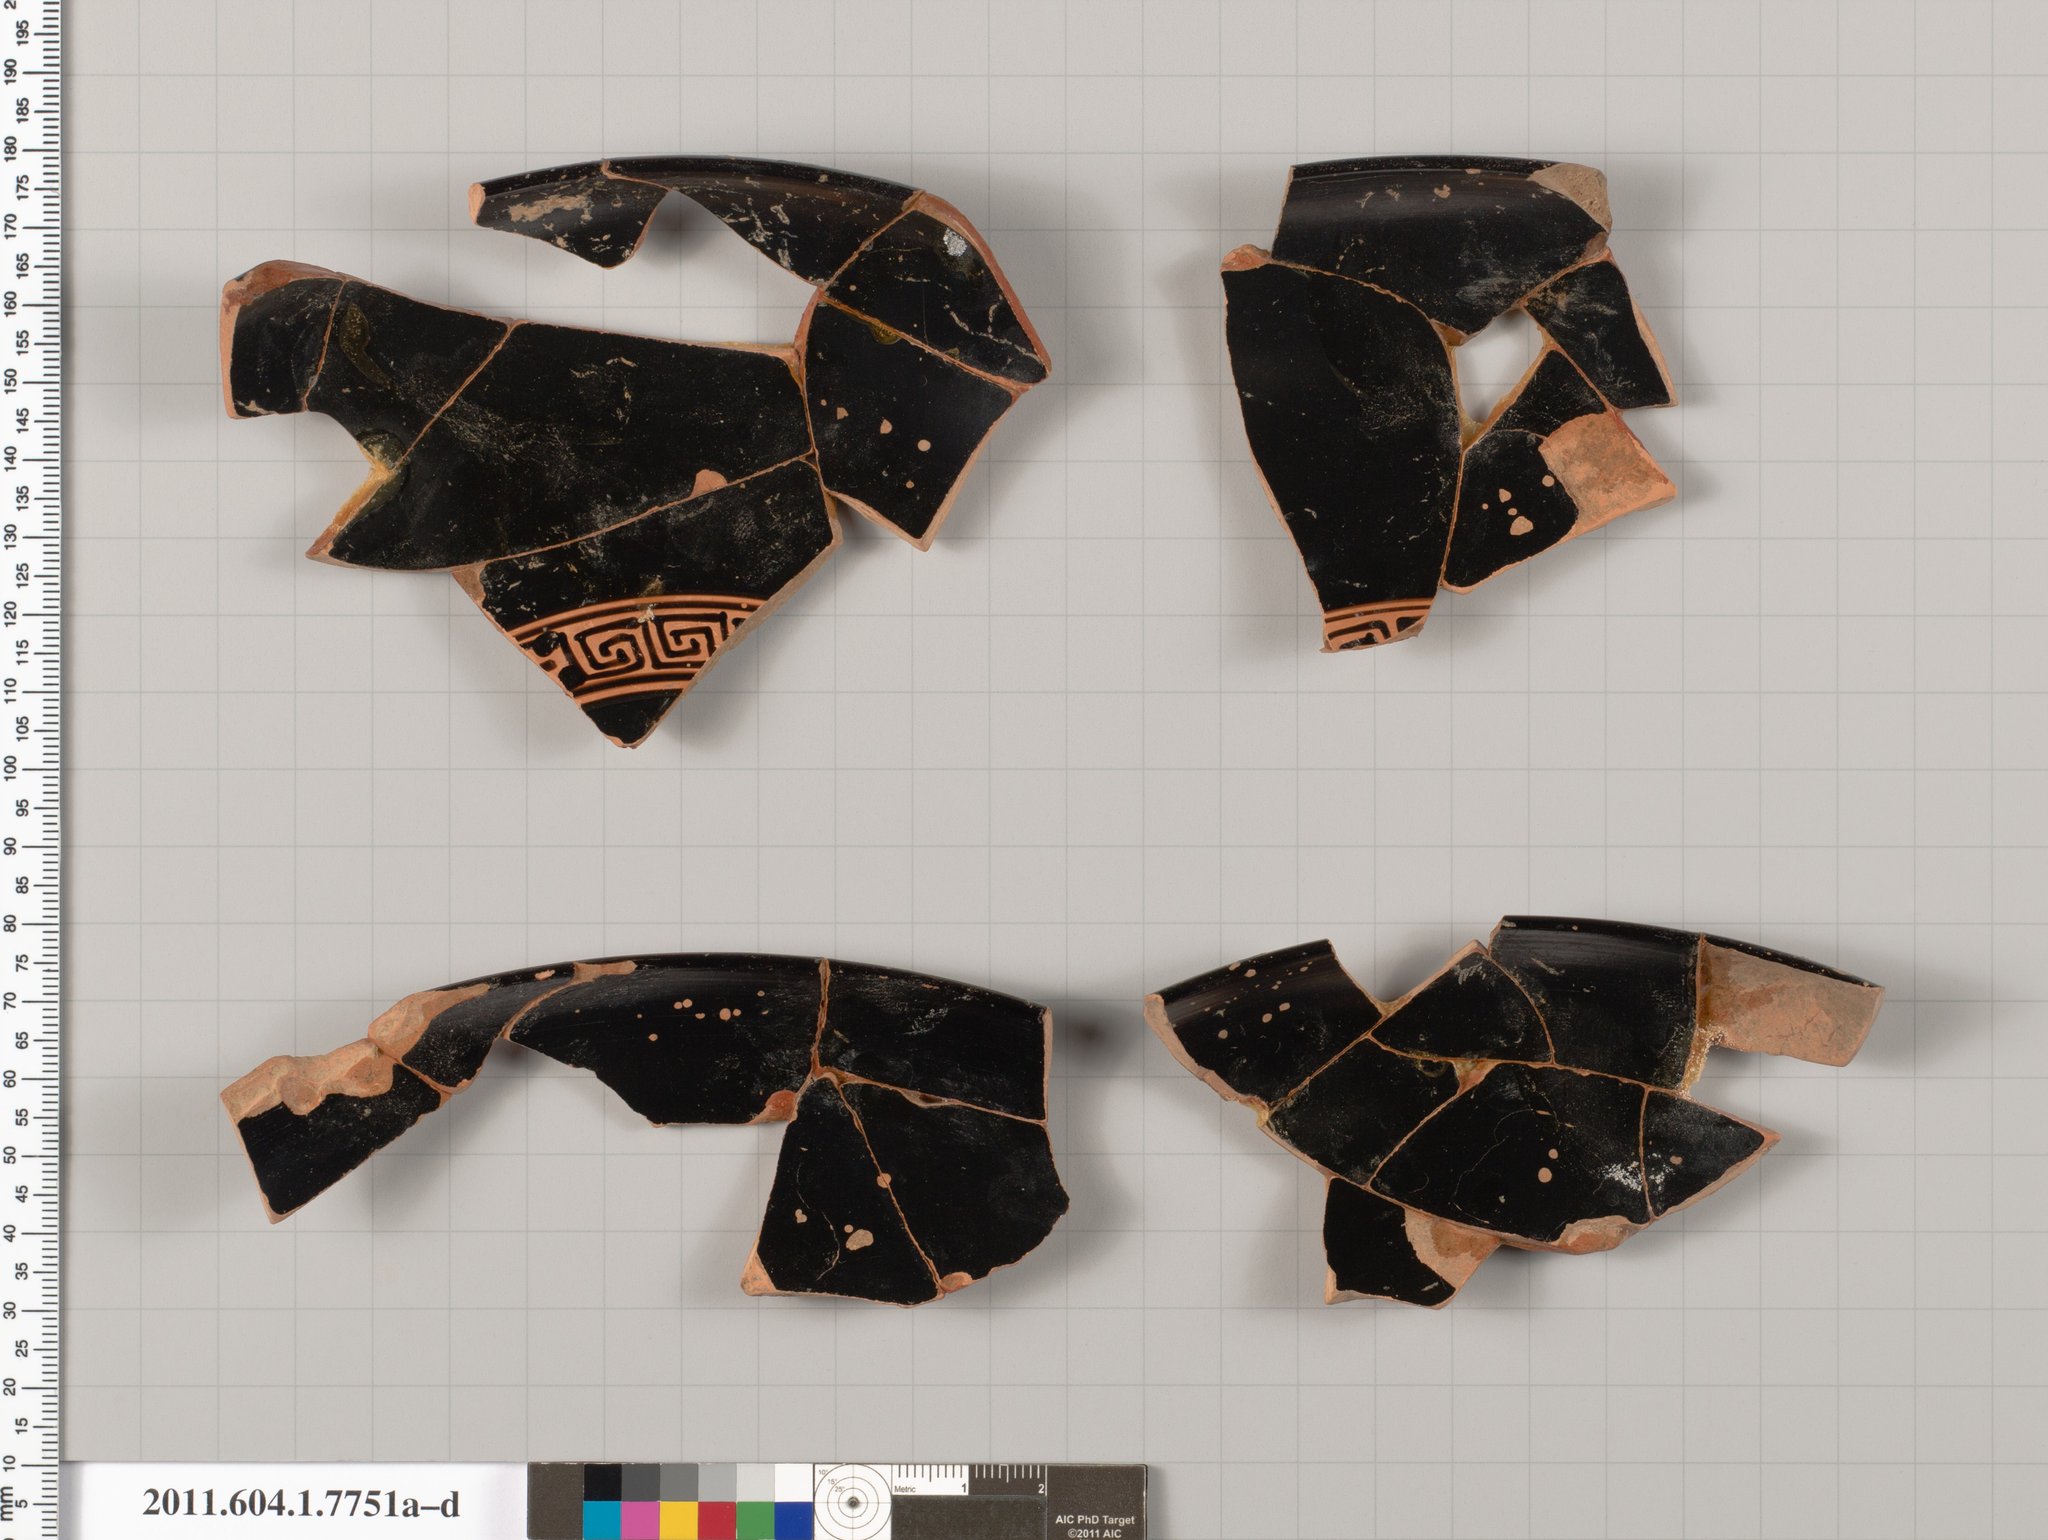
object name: kylix fragment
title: Terracotta rim fragments of a kylix (drinking cup)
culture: greek, attic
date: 460-450 BCE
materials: terracotta